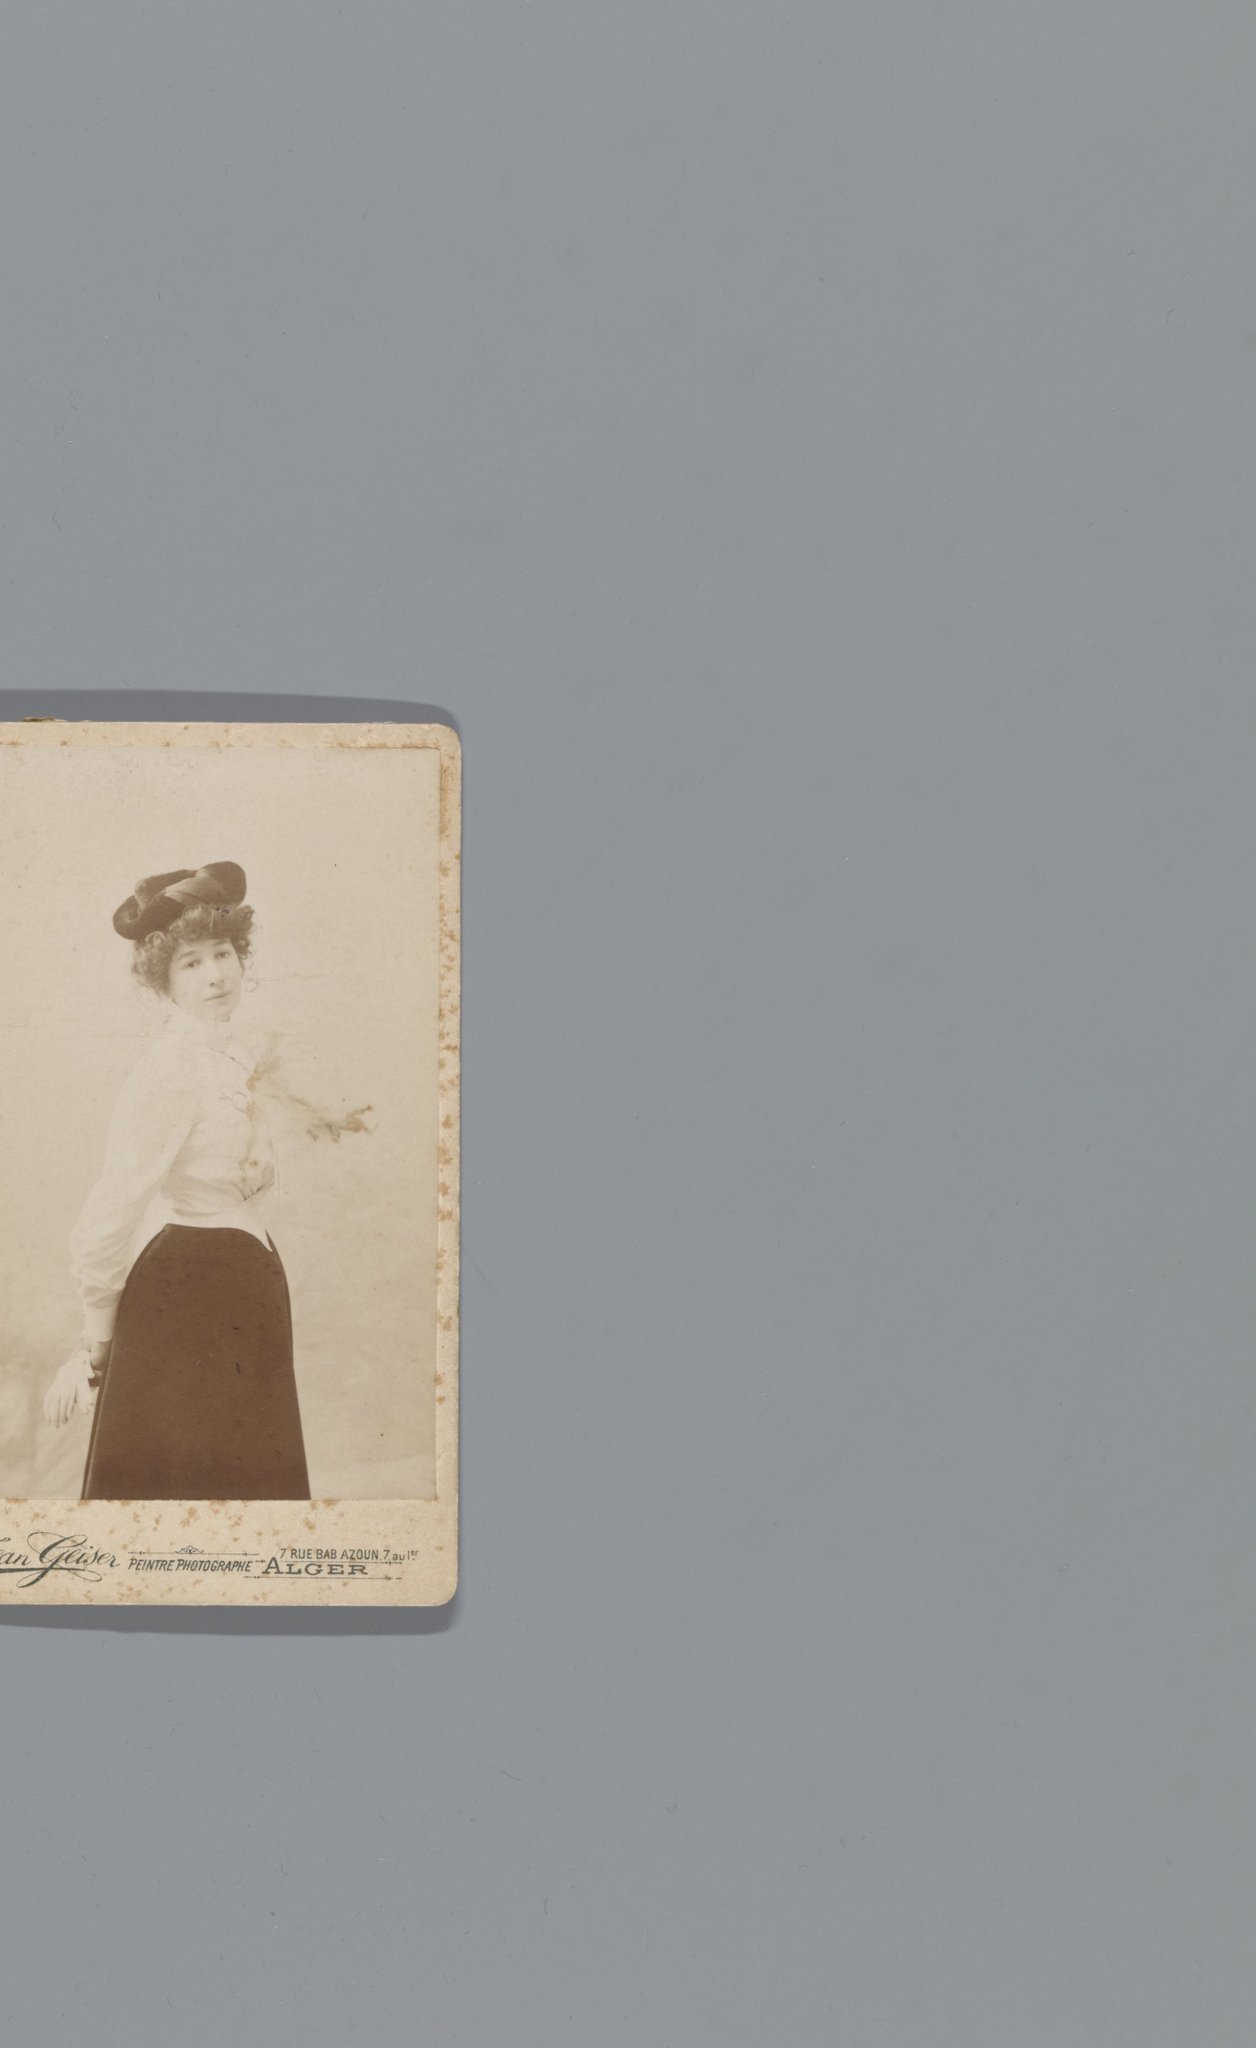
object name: carte de visite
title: Marie Witsen als jonge vrouw (Algiers)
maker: jean geiser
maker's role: fotograaf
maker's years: 1848-1923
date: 1860-1915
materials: cardboard, paper, photographic support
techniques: gelatin silver print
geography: algiers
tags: augusta maria agnes witsen-schorr